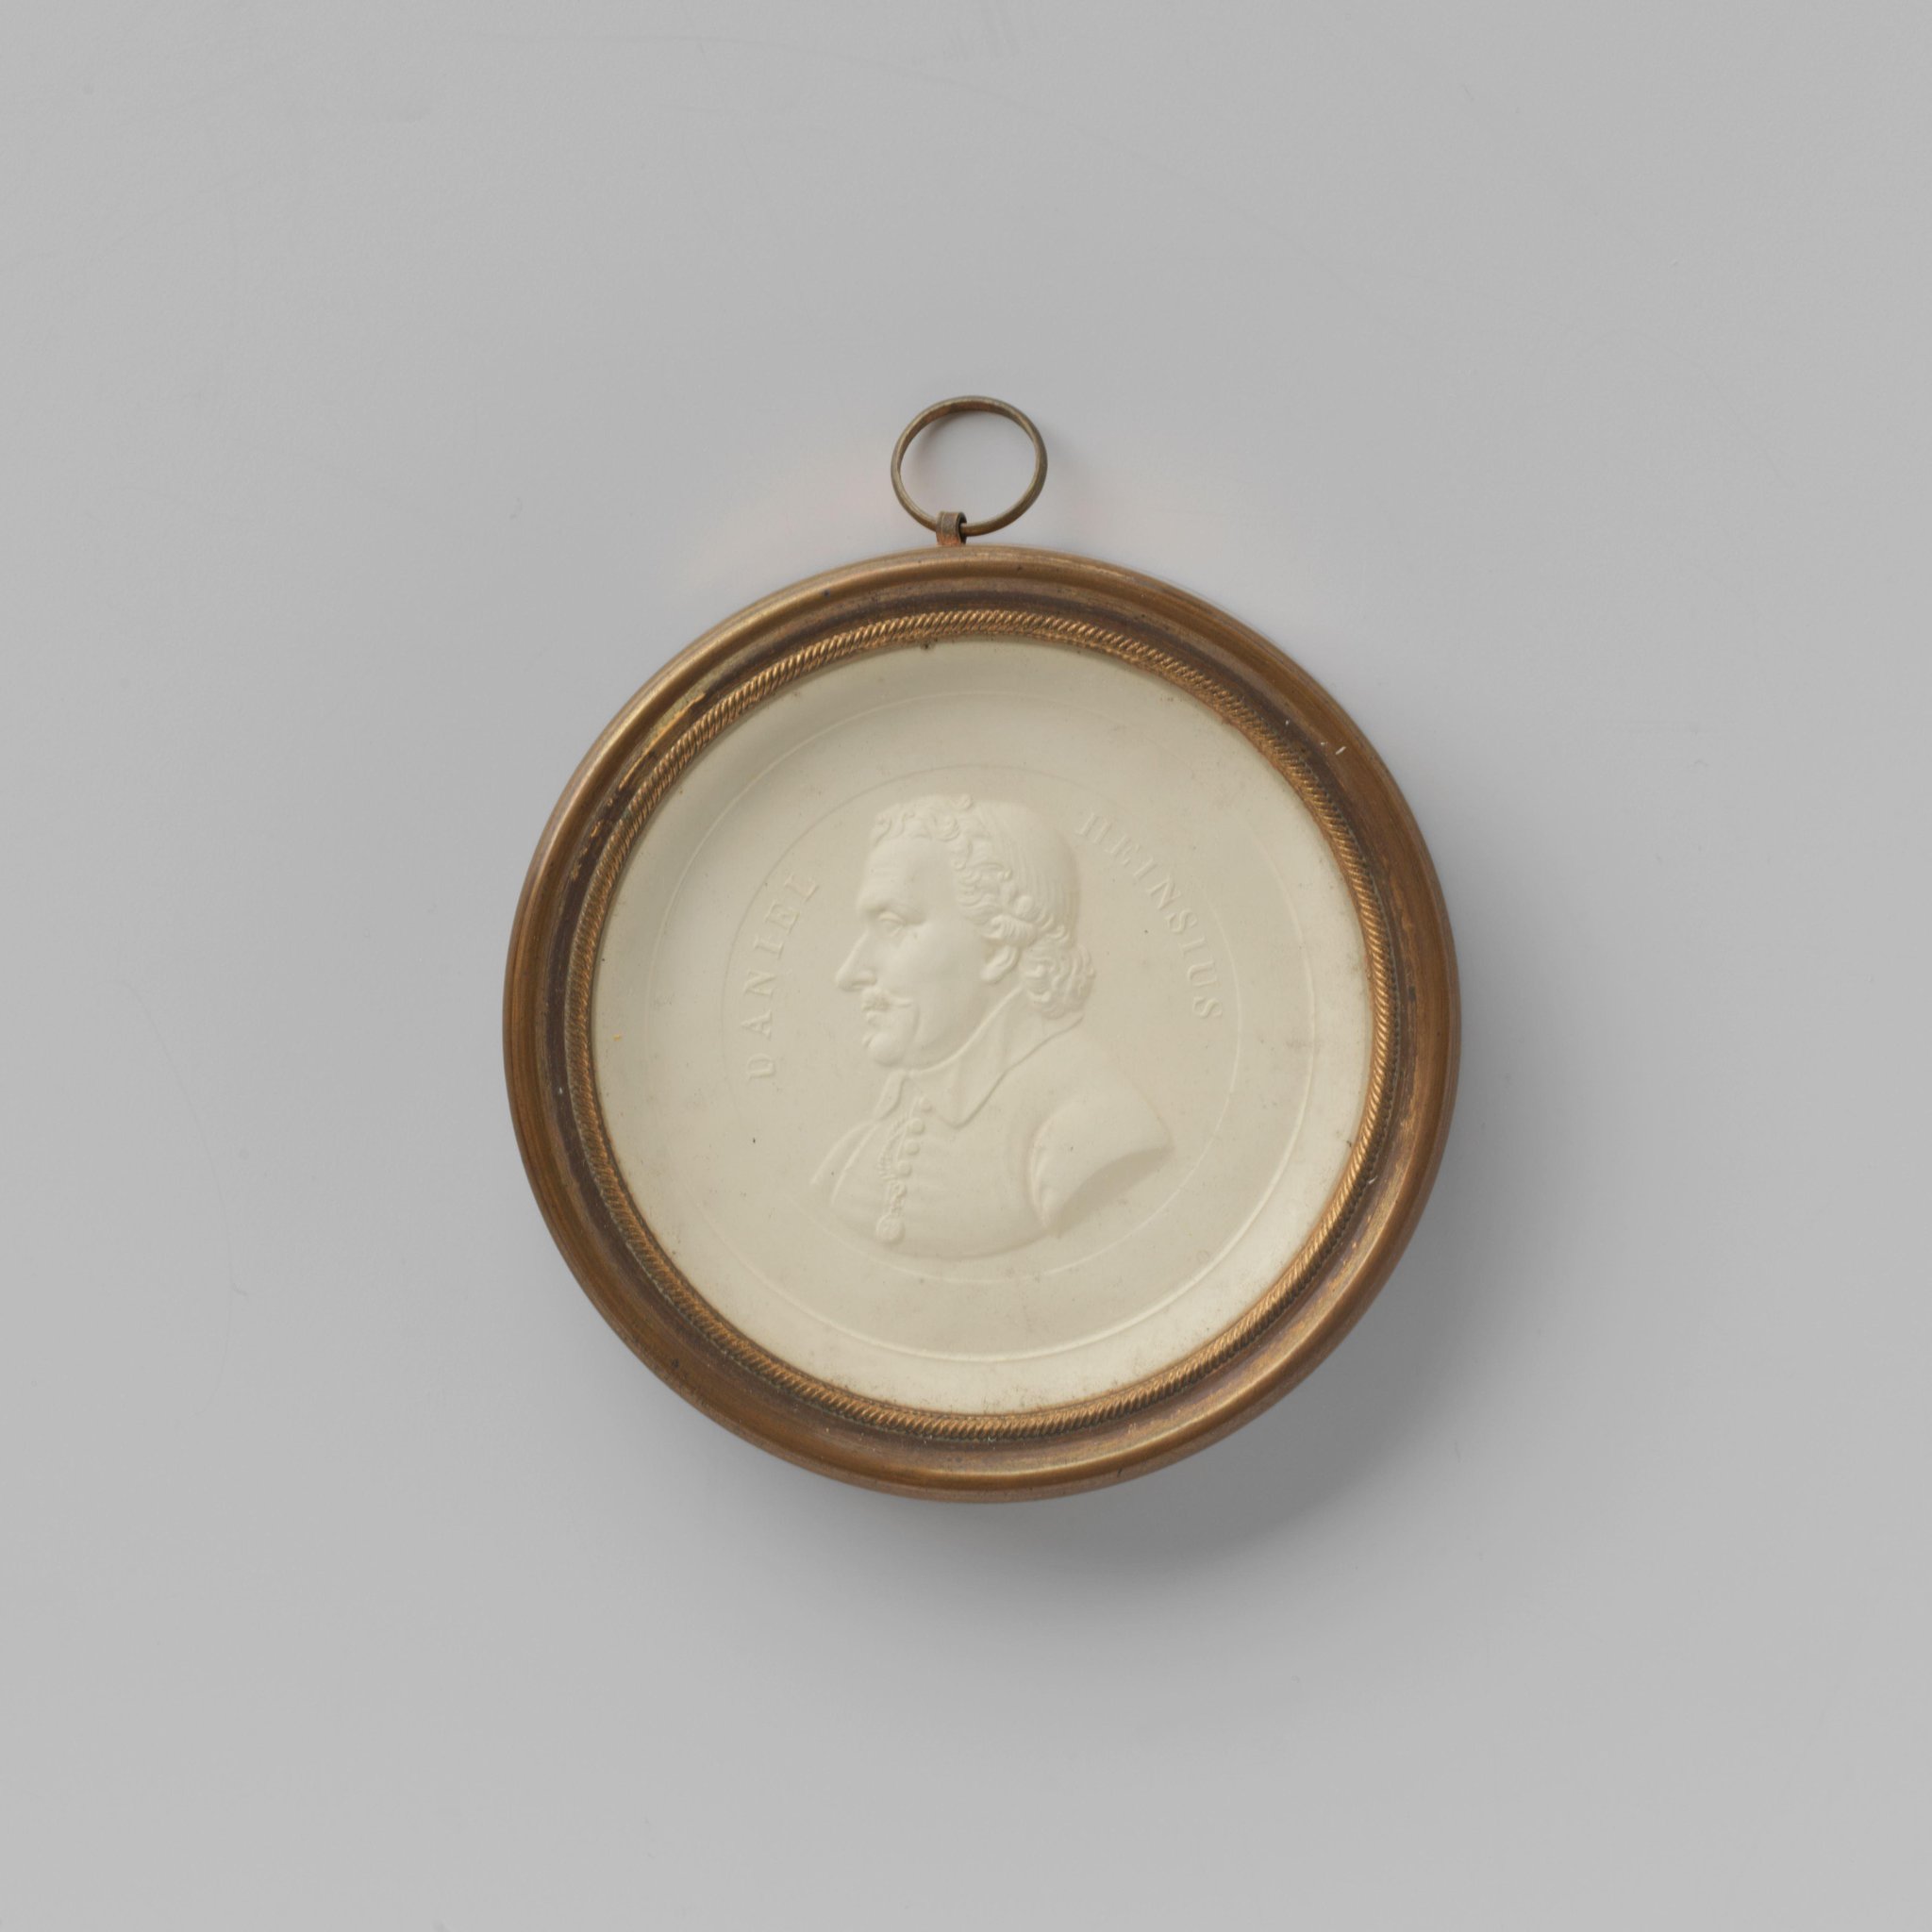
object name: locket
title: Daniel Heinsius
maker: gottfried eichler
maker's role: draughtsman, painter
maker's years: 1677-1757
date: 1687-1757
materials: brass, glass, gypsum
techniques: casting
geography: berlin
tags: ghent, leiden, daniël heinsius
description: Eenzijdig medaillon in messing ring achter glas aan draagoog en draagring. Voorzijde: borststuk man naar links binnen omschrift. Keerzijde: etiket met opschrift.